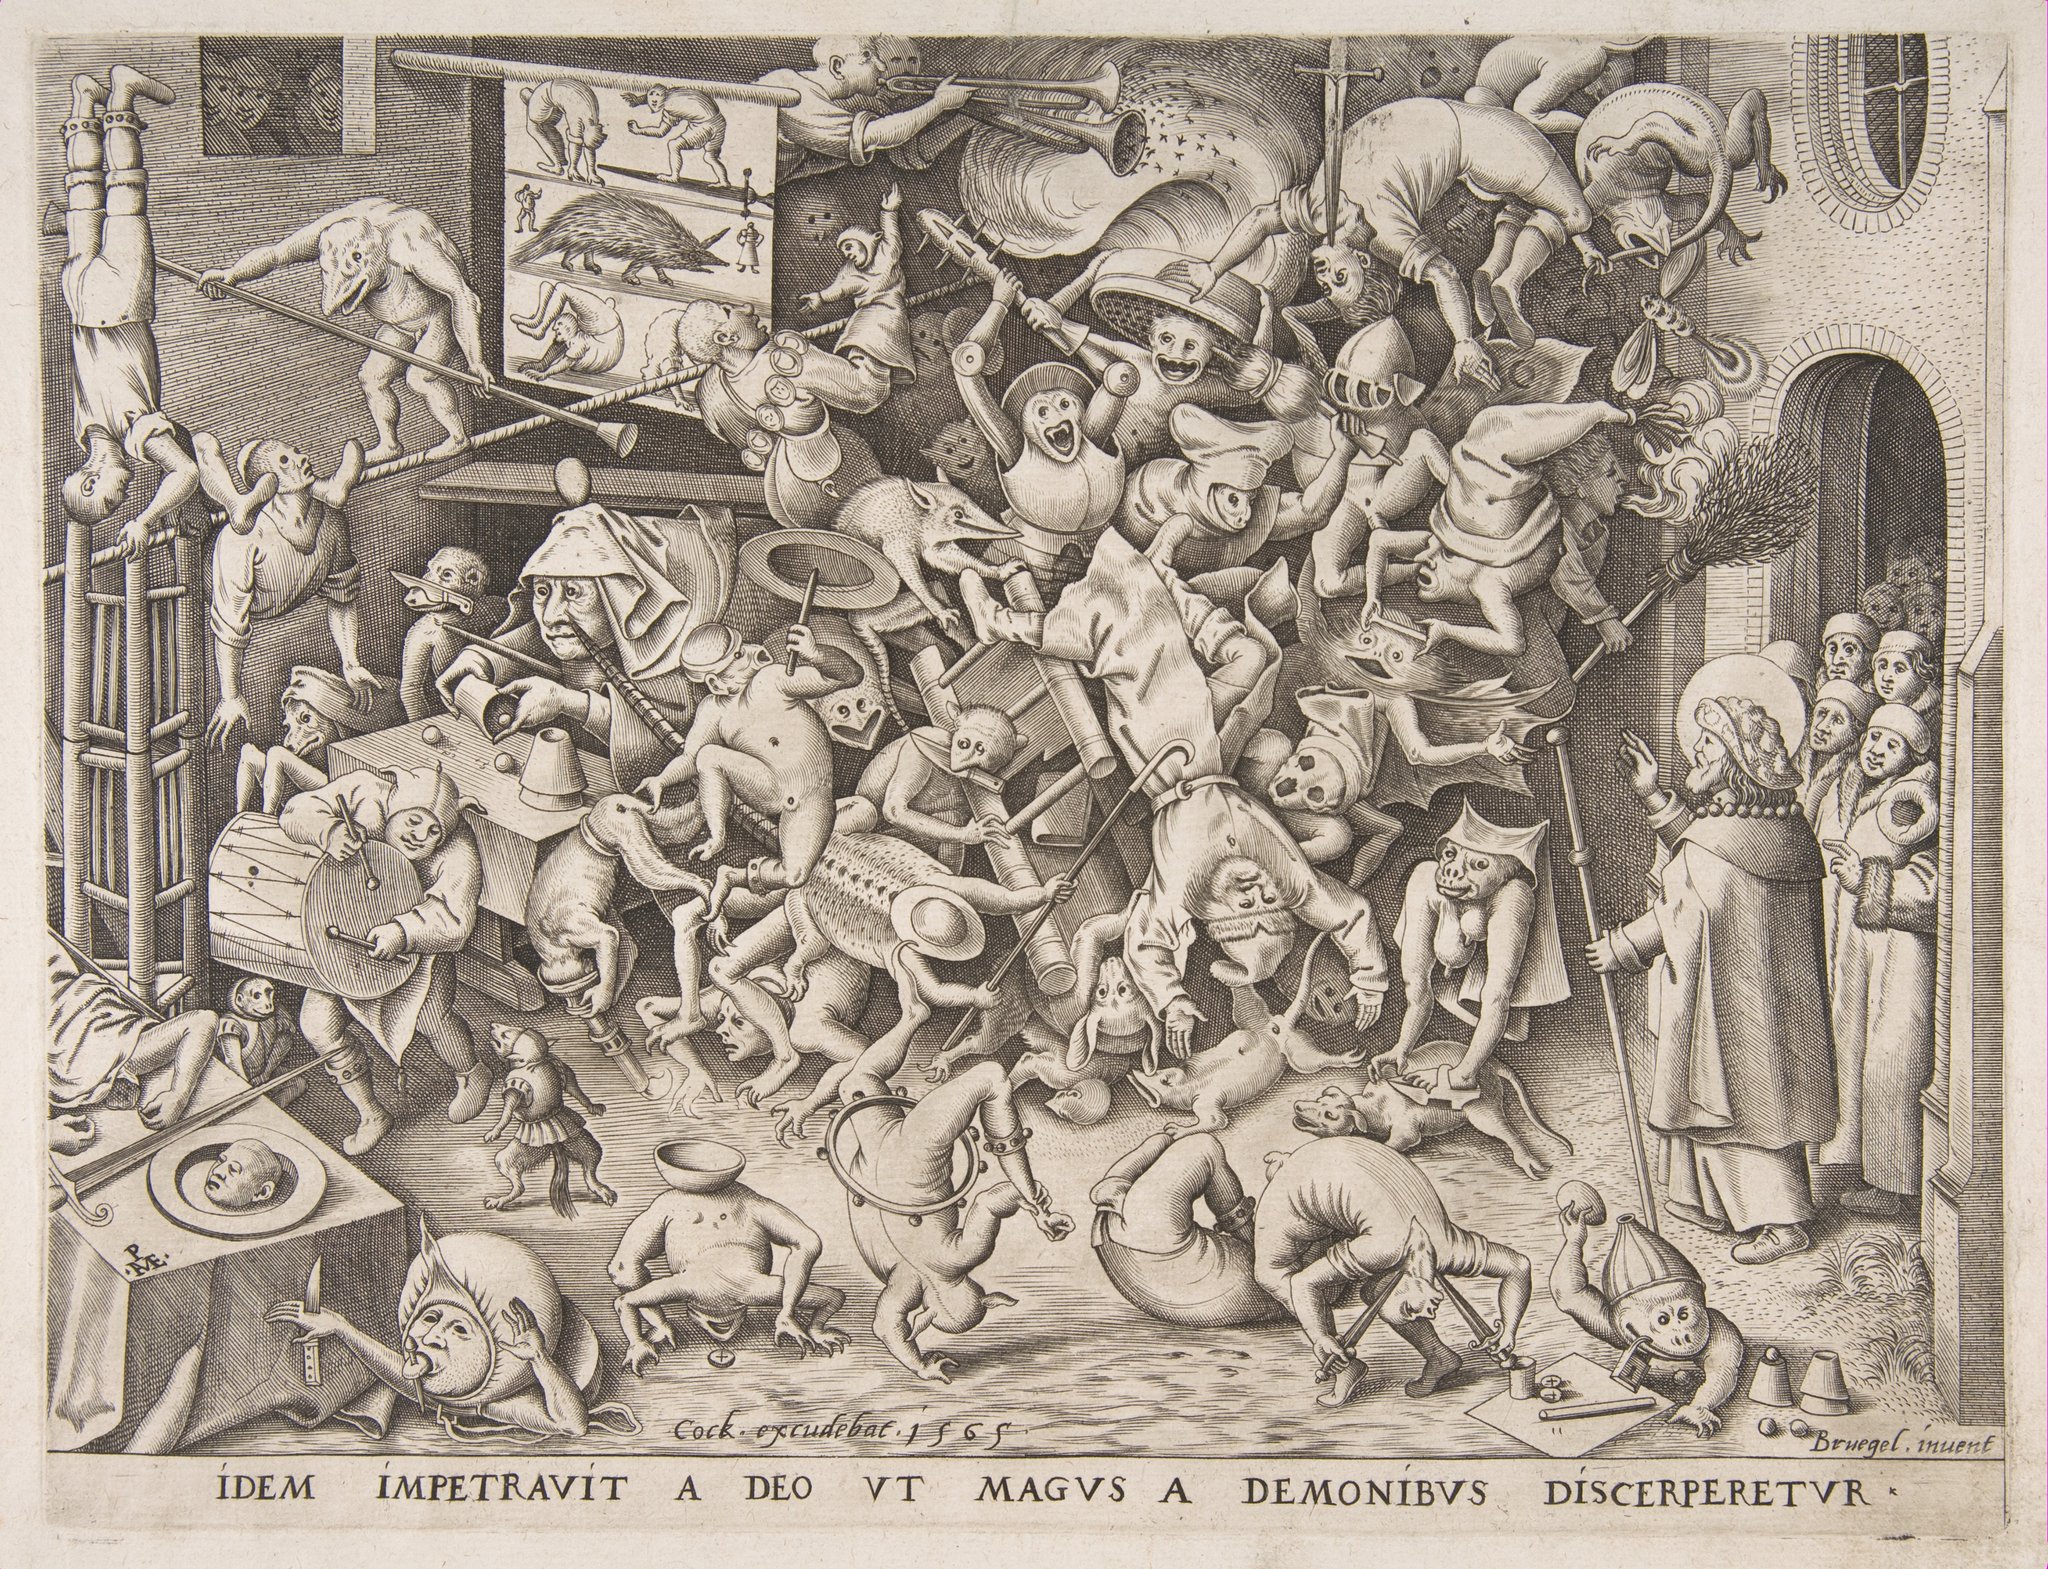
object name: print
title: The Fall of the Magician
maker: pieter van der heyden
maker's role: artist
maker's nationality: netherlandish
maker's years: 1525-1569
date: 1565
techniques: engraving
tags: musical instruments,animals,circus,magicians